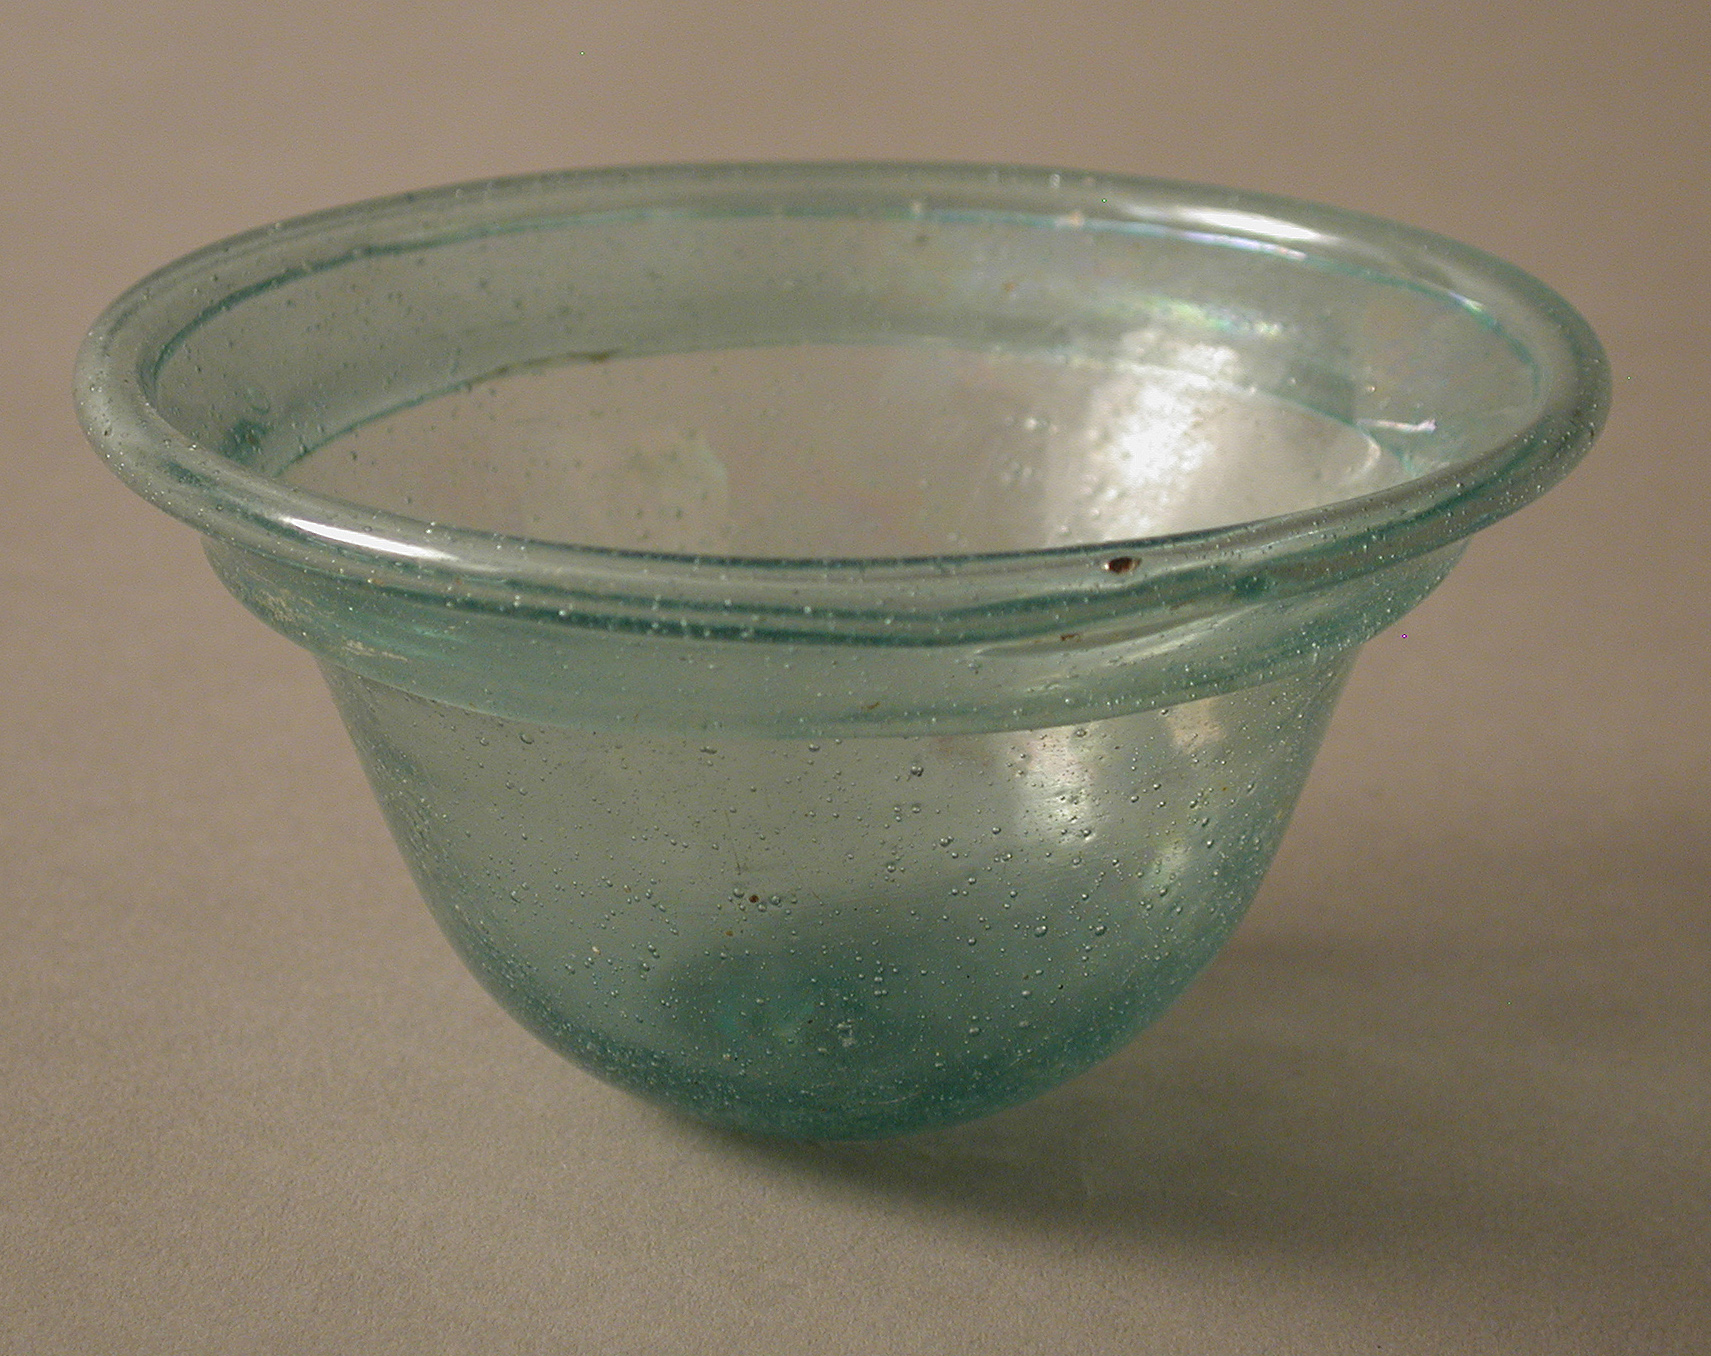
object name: cup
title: Palm Cup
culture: frankish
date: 601-800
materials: glass